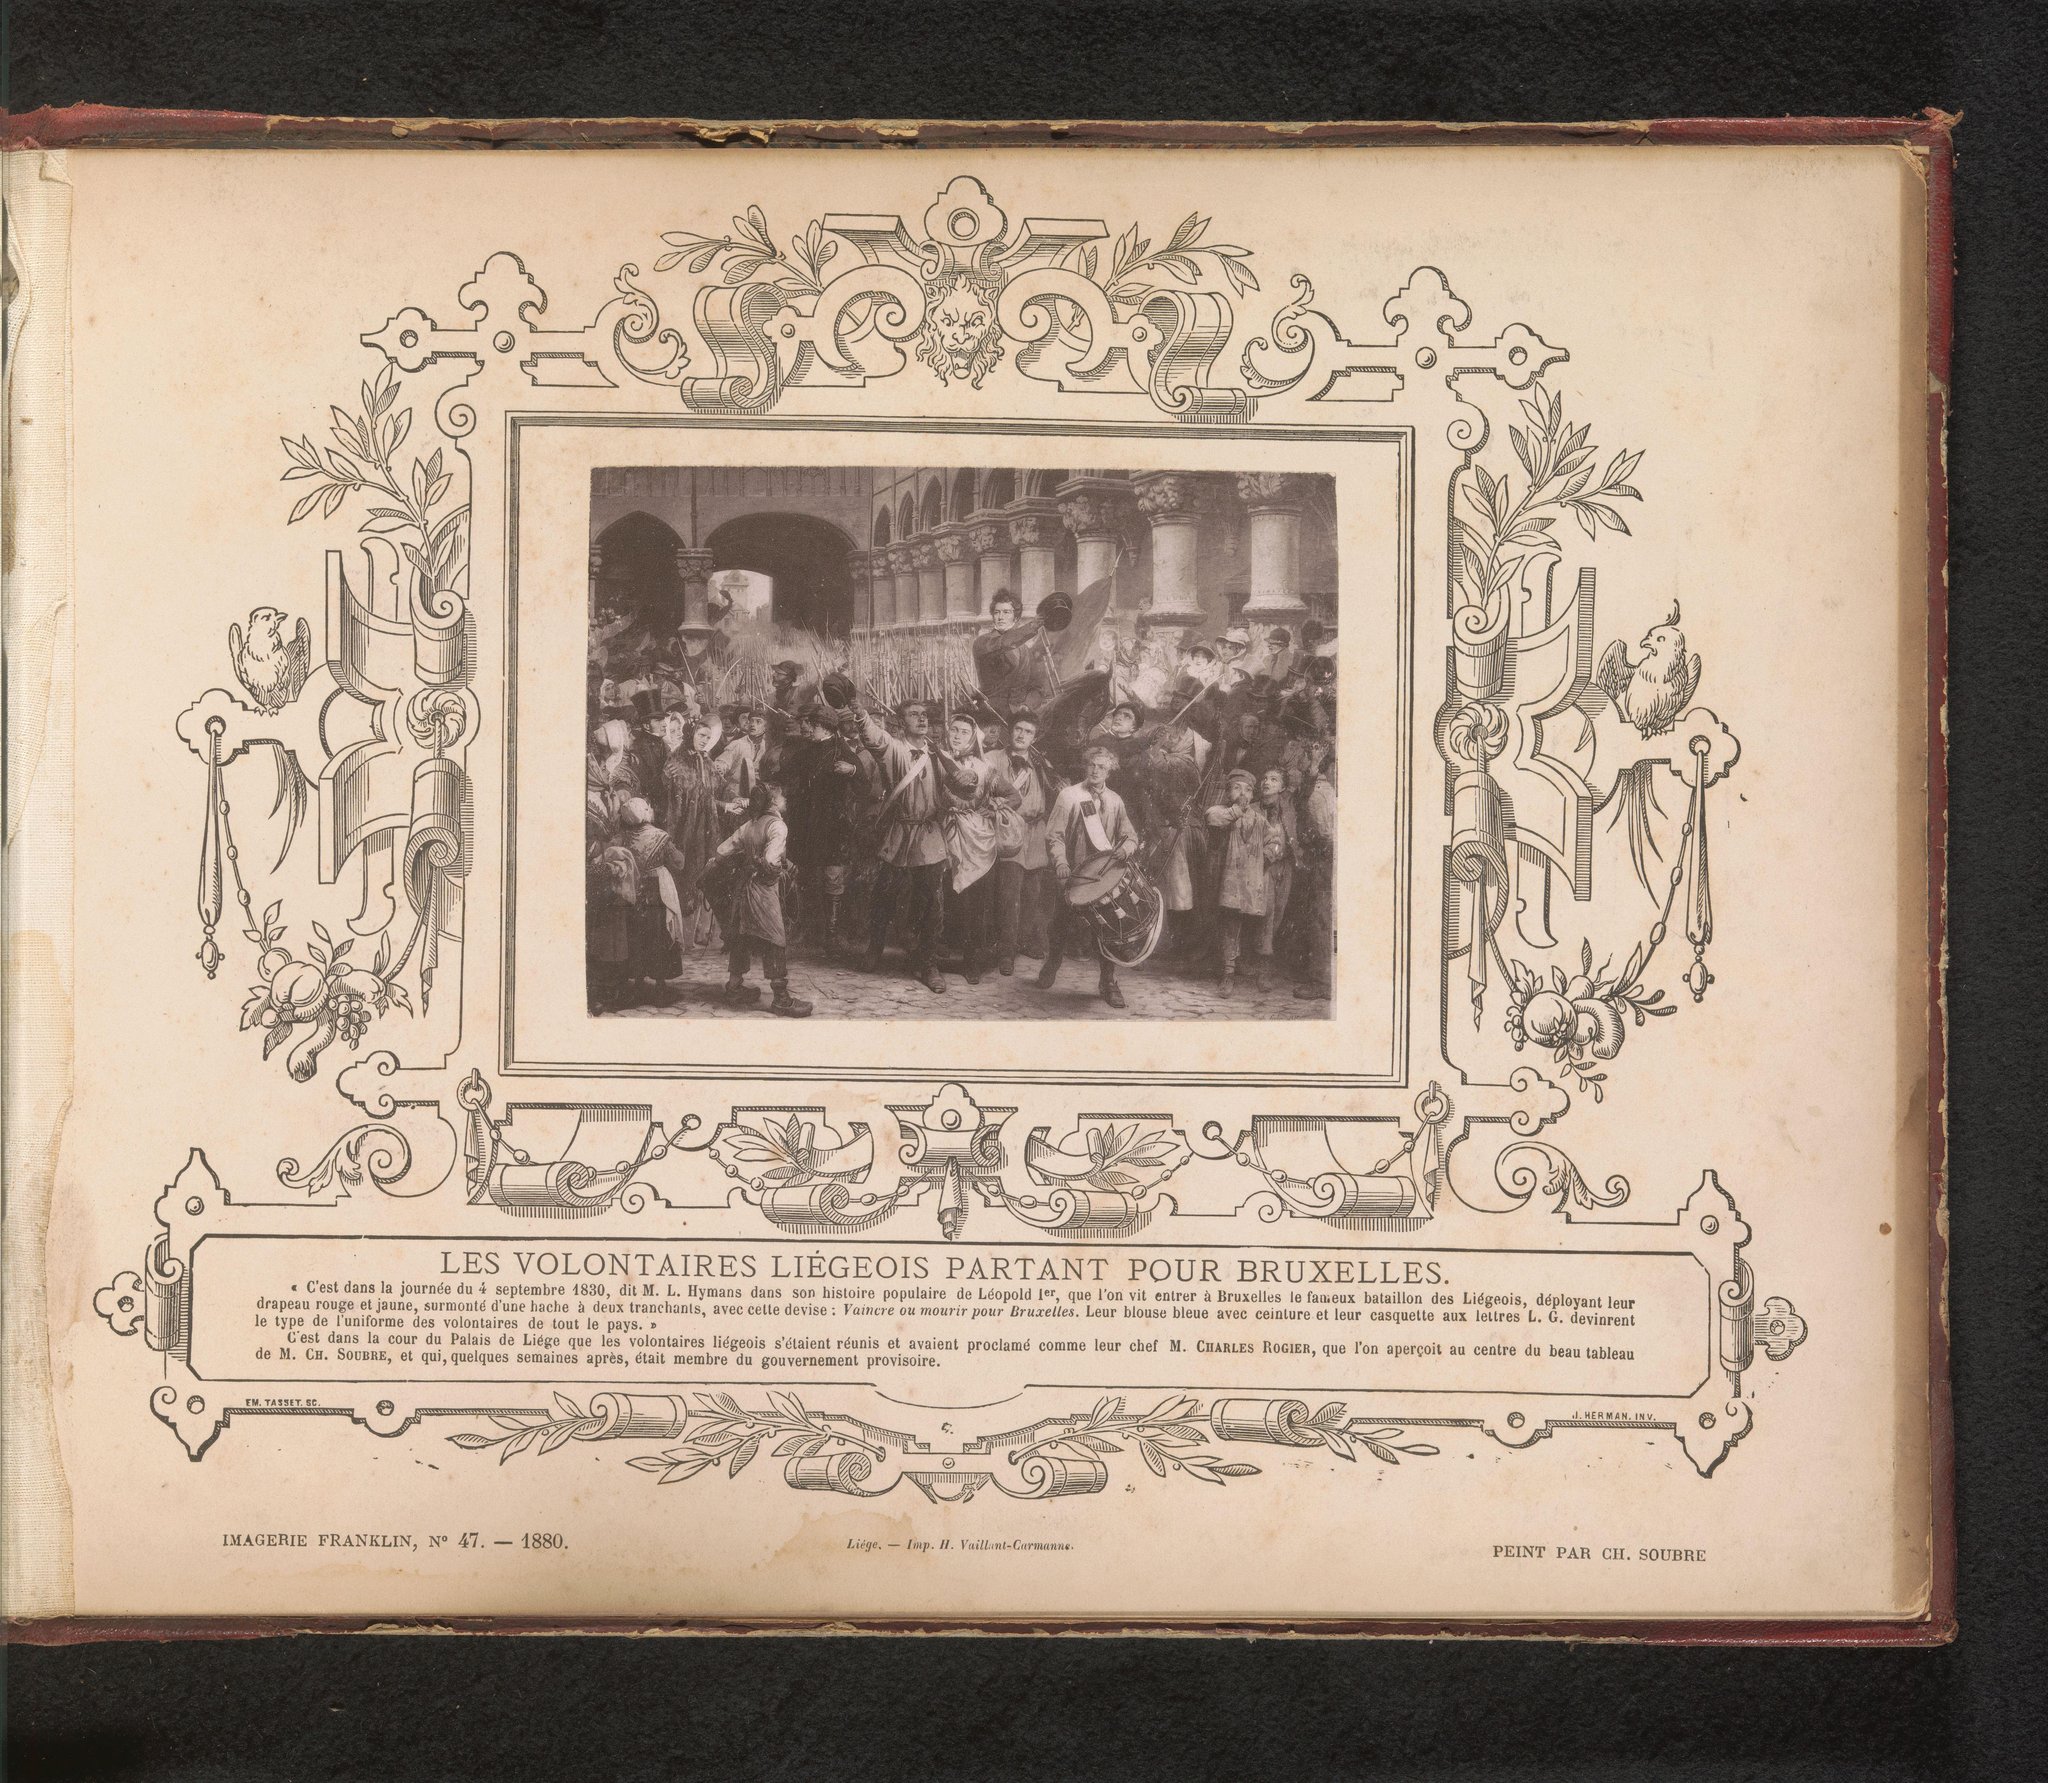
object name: photomechanical print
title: Reproductie van een schilderij van vrijwilligers uit Luik die naar Brussel vertrekken door Charles Soubre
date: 1875-1880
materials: paper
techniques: woodburytype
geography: liège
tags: volunteers ~ enlisting, liège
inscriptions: inscription: ‘<< C'est dans (...) gouvernement provisoire.’, inscription: ‘IMAGERIE FRANKLIN, No 47. - 1880.’, name: ‘J. HERMAN, INV.’, name: ‘EM. TASSET, SC.’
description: Deze prent maakt deel uit van een album.